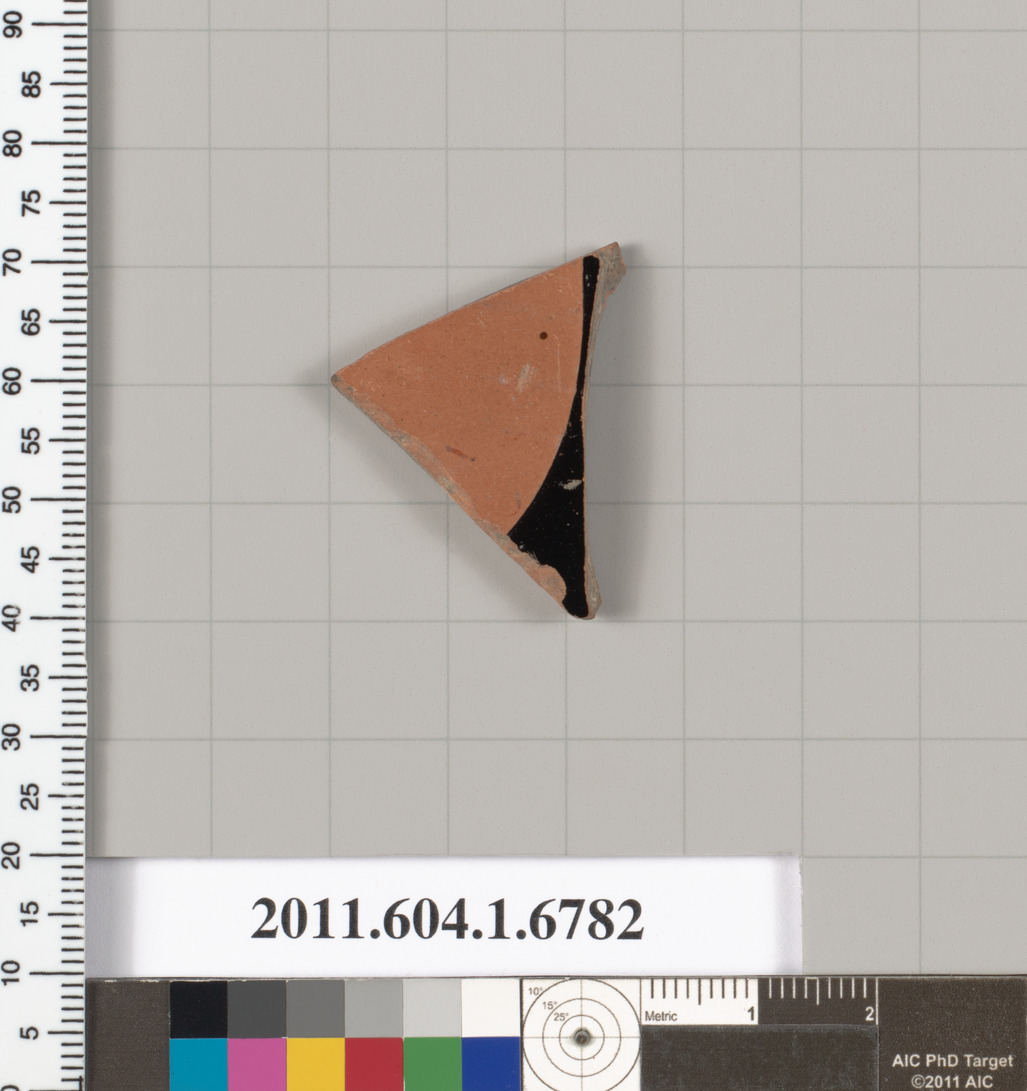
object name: kylix fragment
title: Terracotta fragment of a kylix (drinking cup)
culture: greek, attic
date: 490-470 BCE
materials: terracotta